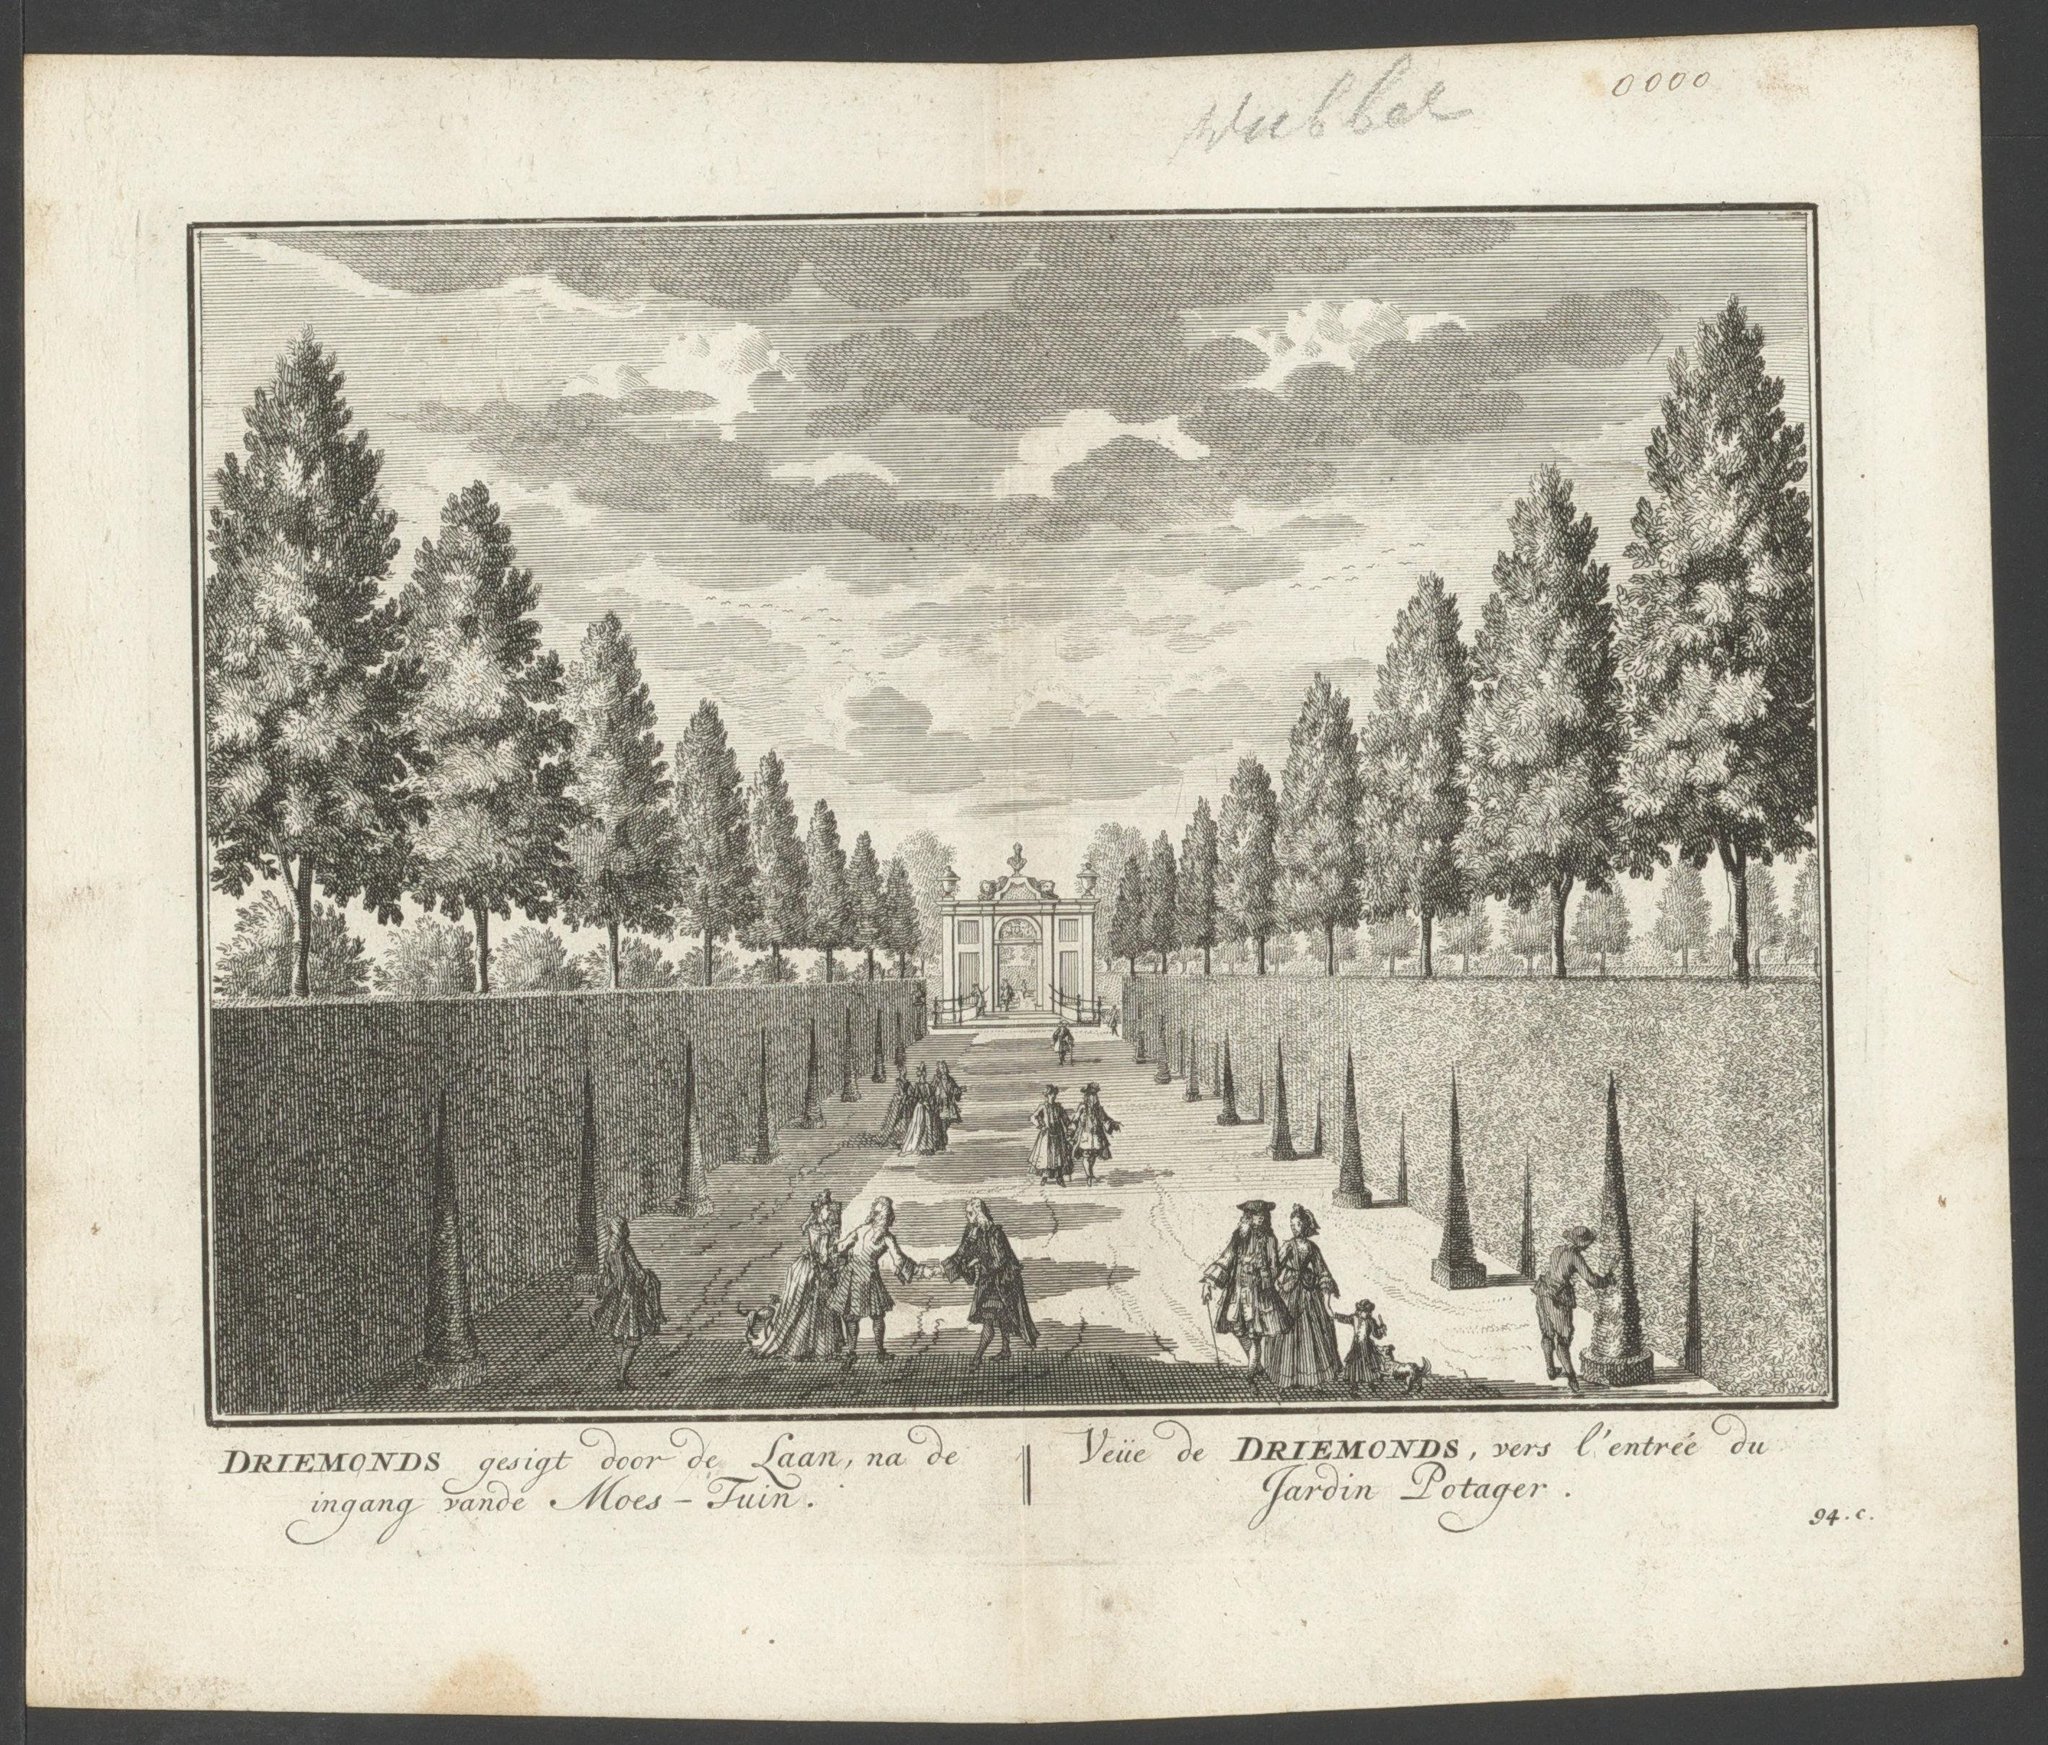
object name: print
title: Driemonds gesigt door de Laan, na de ingang vande Moes-Tuin / Veüe de Driemonds, vers l'entrée du Jardin Potager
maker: daniël stopendaal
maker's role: print maker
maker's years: 1672-1726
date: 1790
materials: paper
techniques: engraving, etching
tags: french or architectonic garden; formal garden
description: Prent voor het eerst gebruikt in: Leth, Andries de. De zegepraalende Vecht, vertoonende verscheidene gesichten van lustplaatsen, heeren huysen en dorpen, beginnende van Uitrecht en met Muyden besluytende (...). Amsterdam: Weduwe Nicolaus Visscher, 1719. Prent mogelijk uit: Brouërius van Nidek, Matthaeus. De Vechtstroom, van Utrecht tot Muiden (...). Amsterdam: H. Gartman, W. Vermandel en J.W. Smit, 1790.